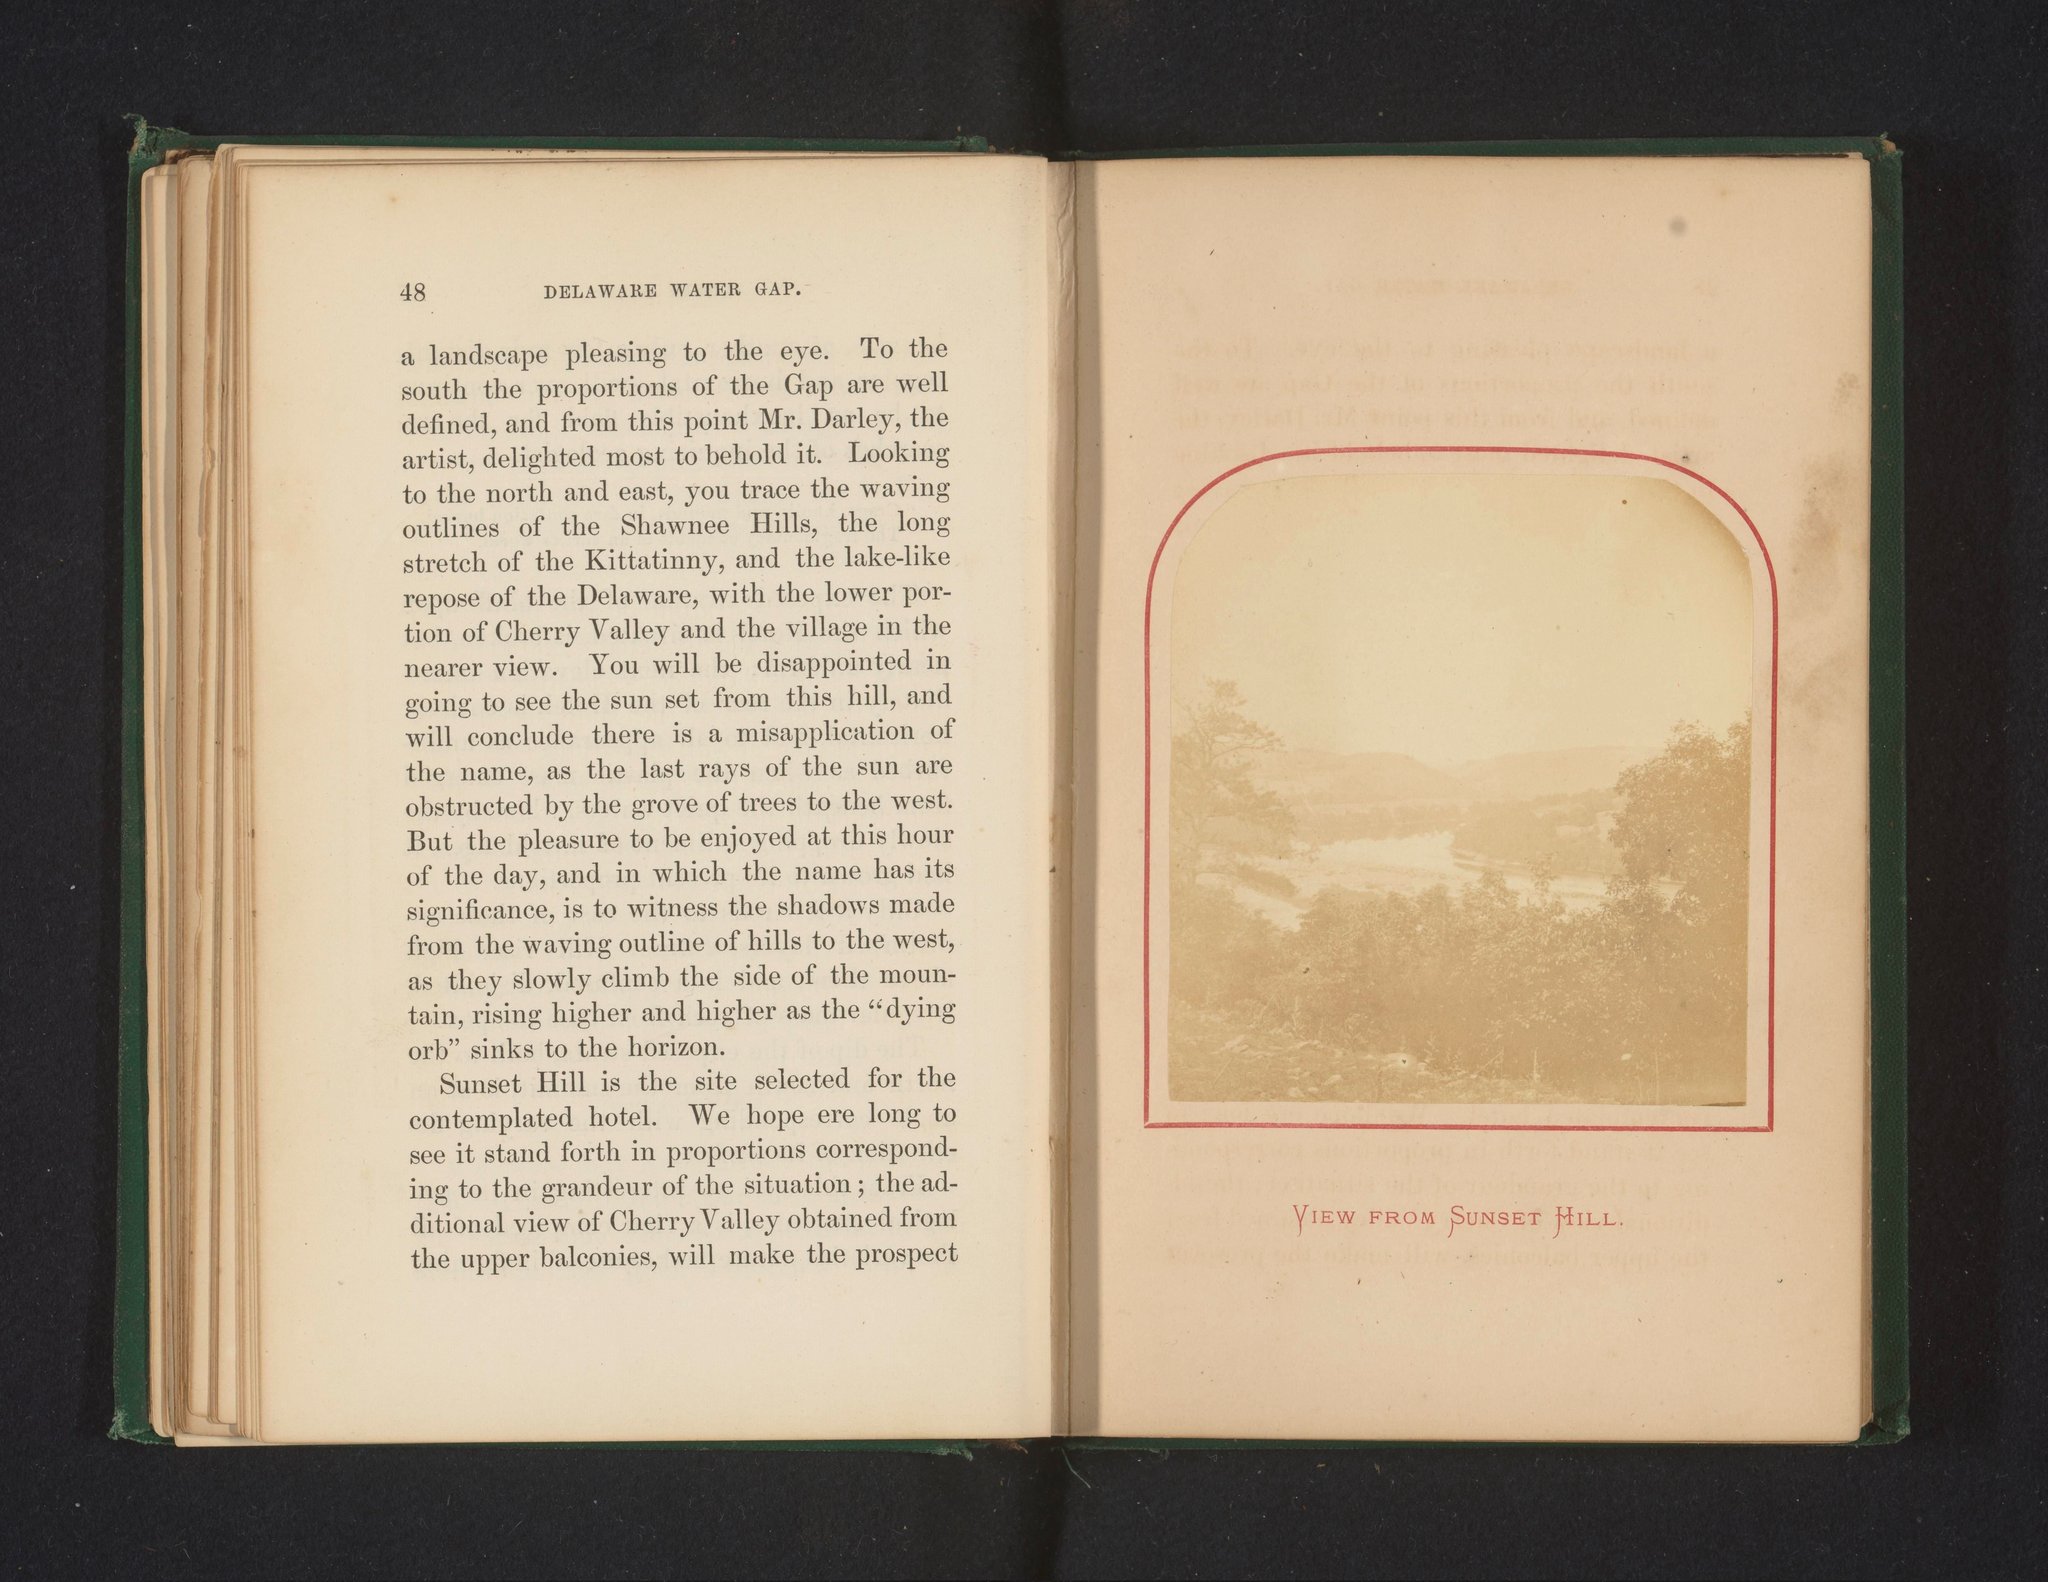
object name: photograph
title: View from Sunset Hill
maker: jesse a. graves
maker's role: fotograaf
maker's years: 1835-1895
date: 1862-1867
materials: photographic support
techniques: albumen print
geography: delaware water gap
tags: low hill country, river